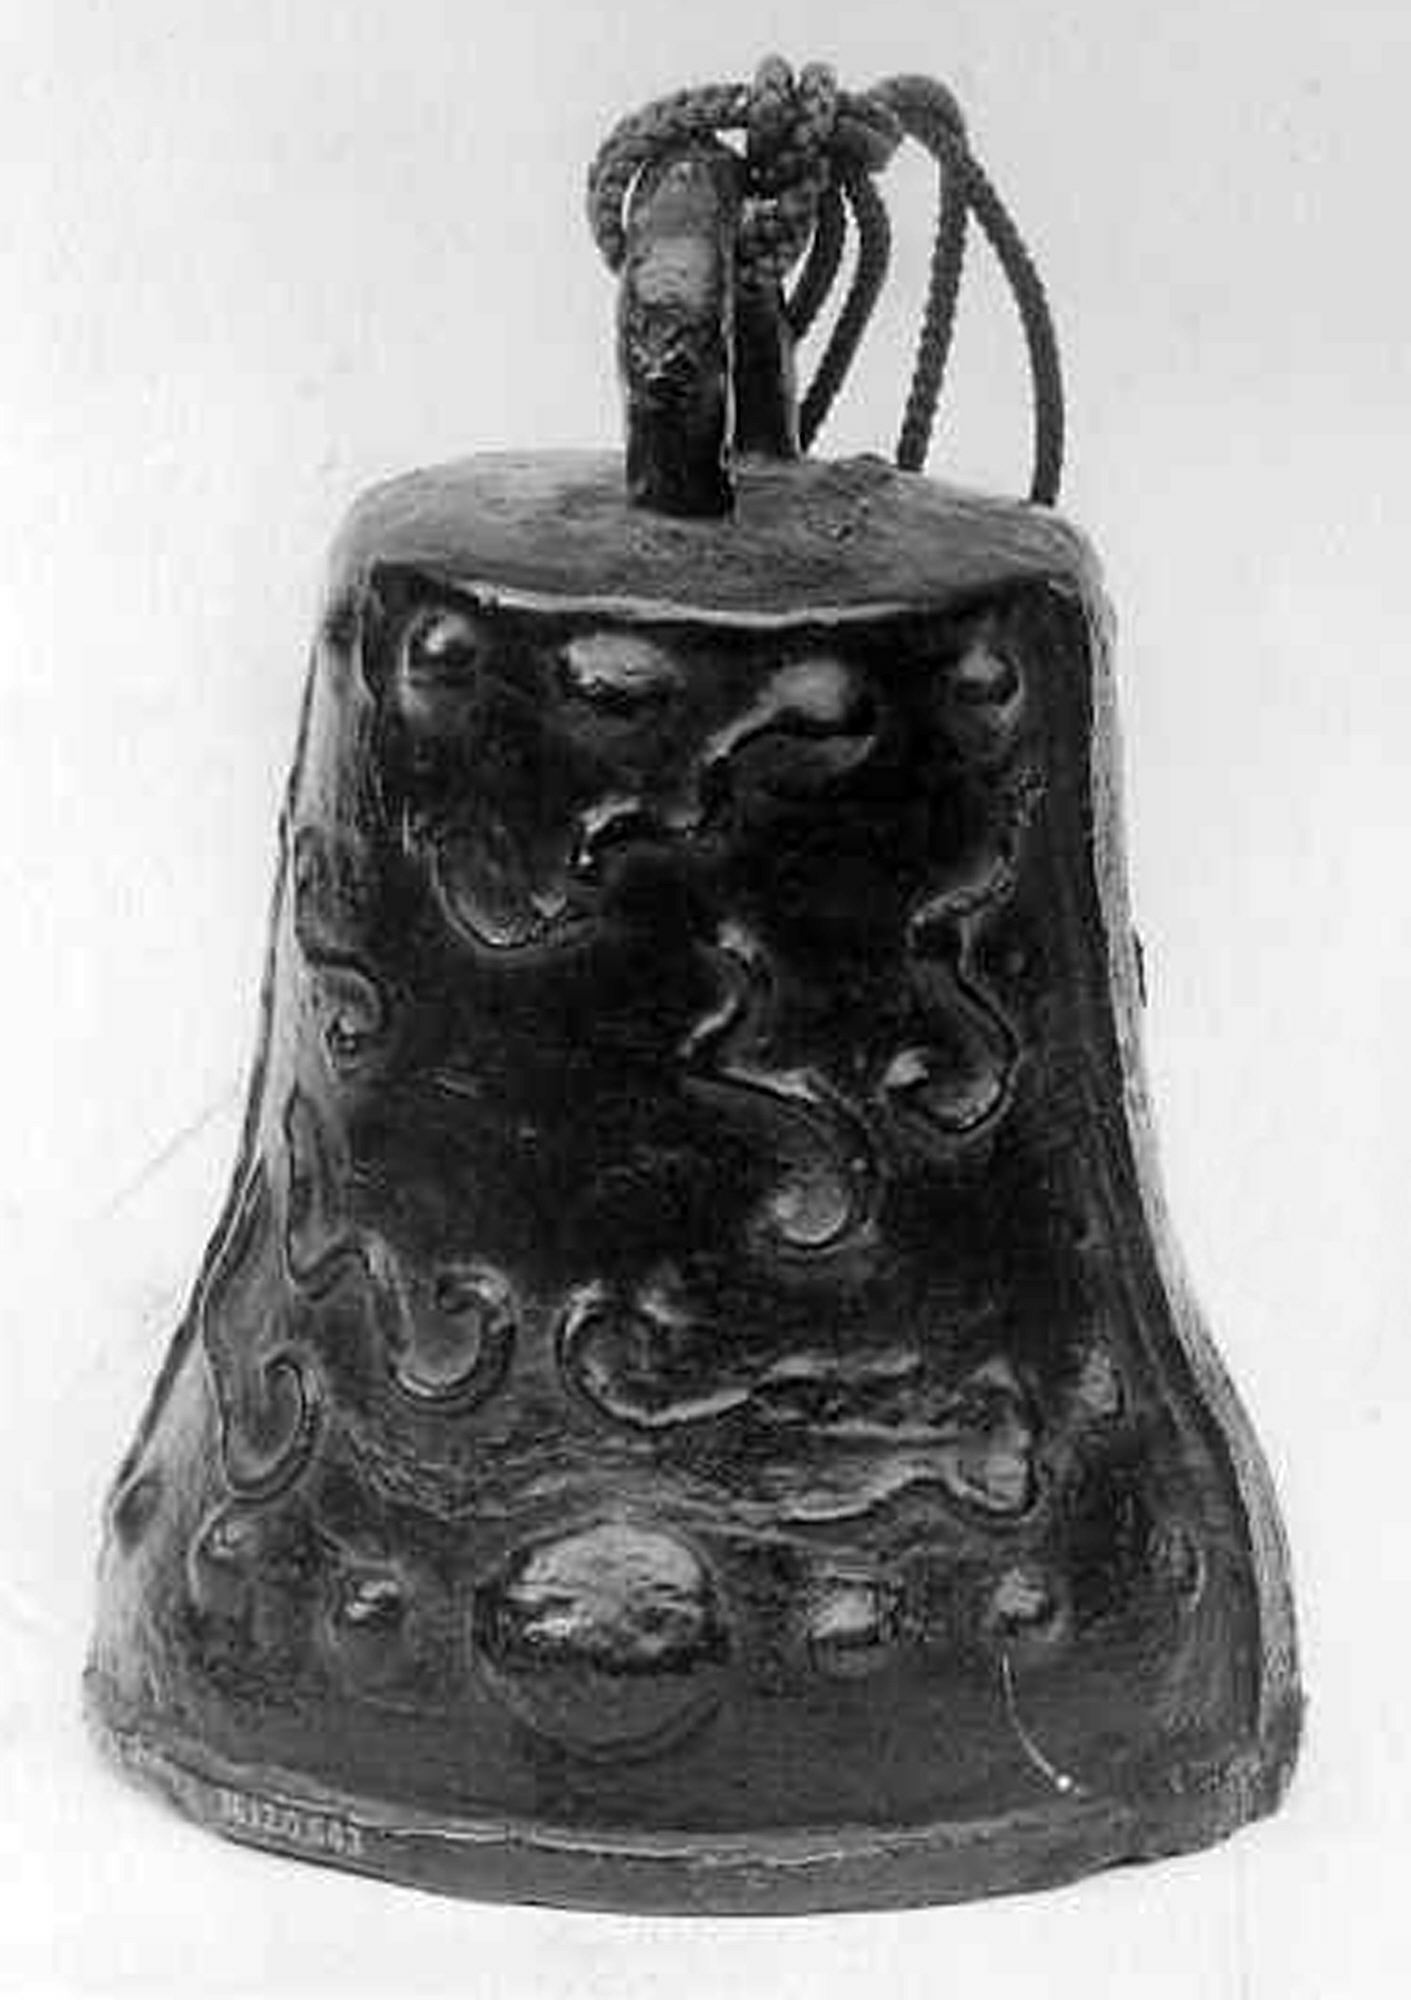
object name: bell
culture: japanese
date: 1601-1700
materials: iron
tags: musical instruments